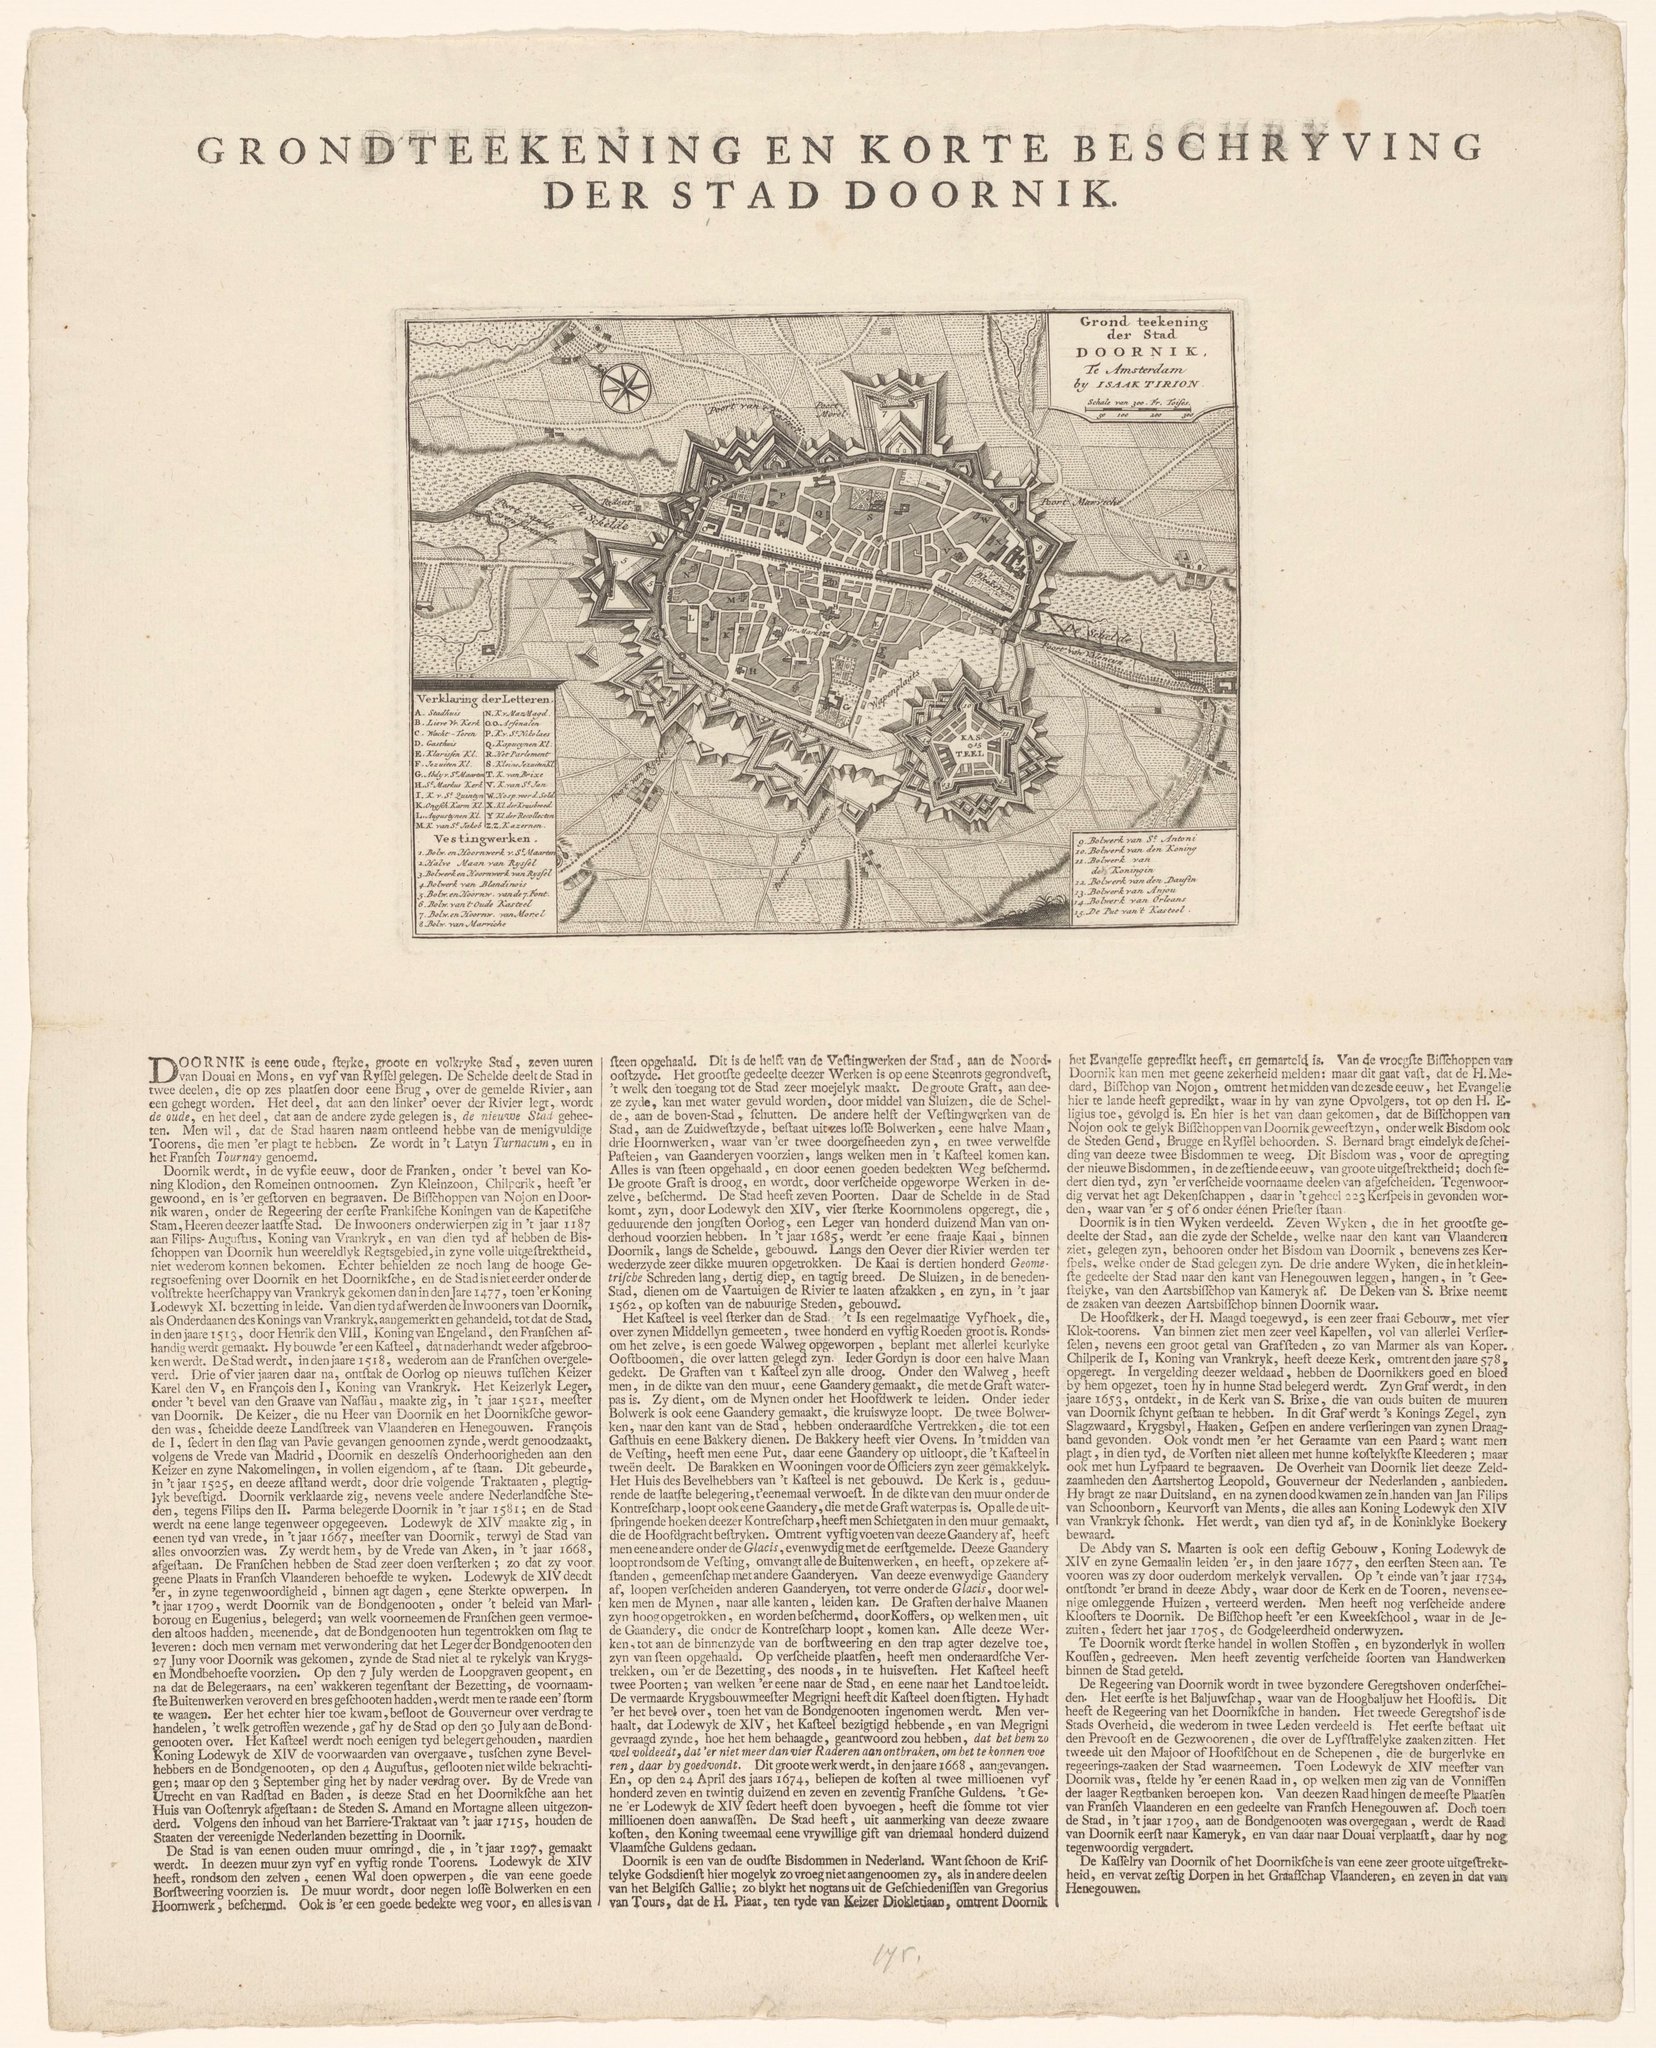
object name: area plan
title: Grond teekening der Stad Doornik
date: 1734-1744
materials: paper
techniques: engraving, etching, letterpress printing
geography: amsterdam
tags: fortified city, maps of cities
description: Plattegrond van de stad Doornik, ingenomen door de Fransen op 24 mei 1745. In de plaat de legenda's A-Z en 1-15. Met een uitvoerige beschrijving van de stad in drie kolommen op het blad onder de plaat in het Nederlands.